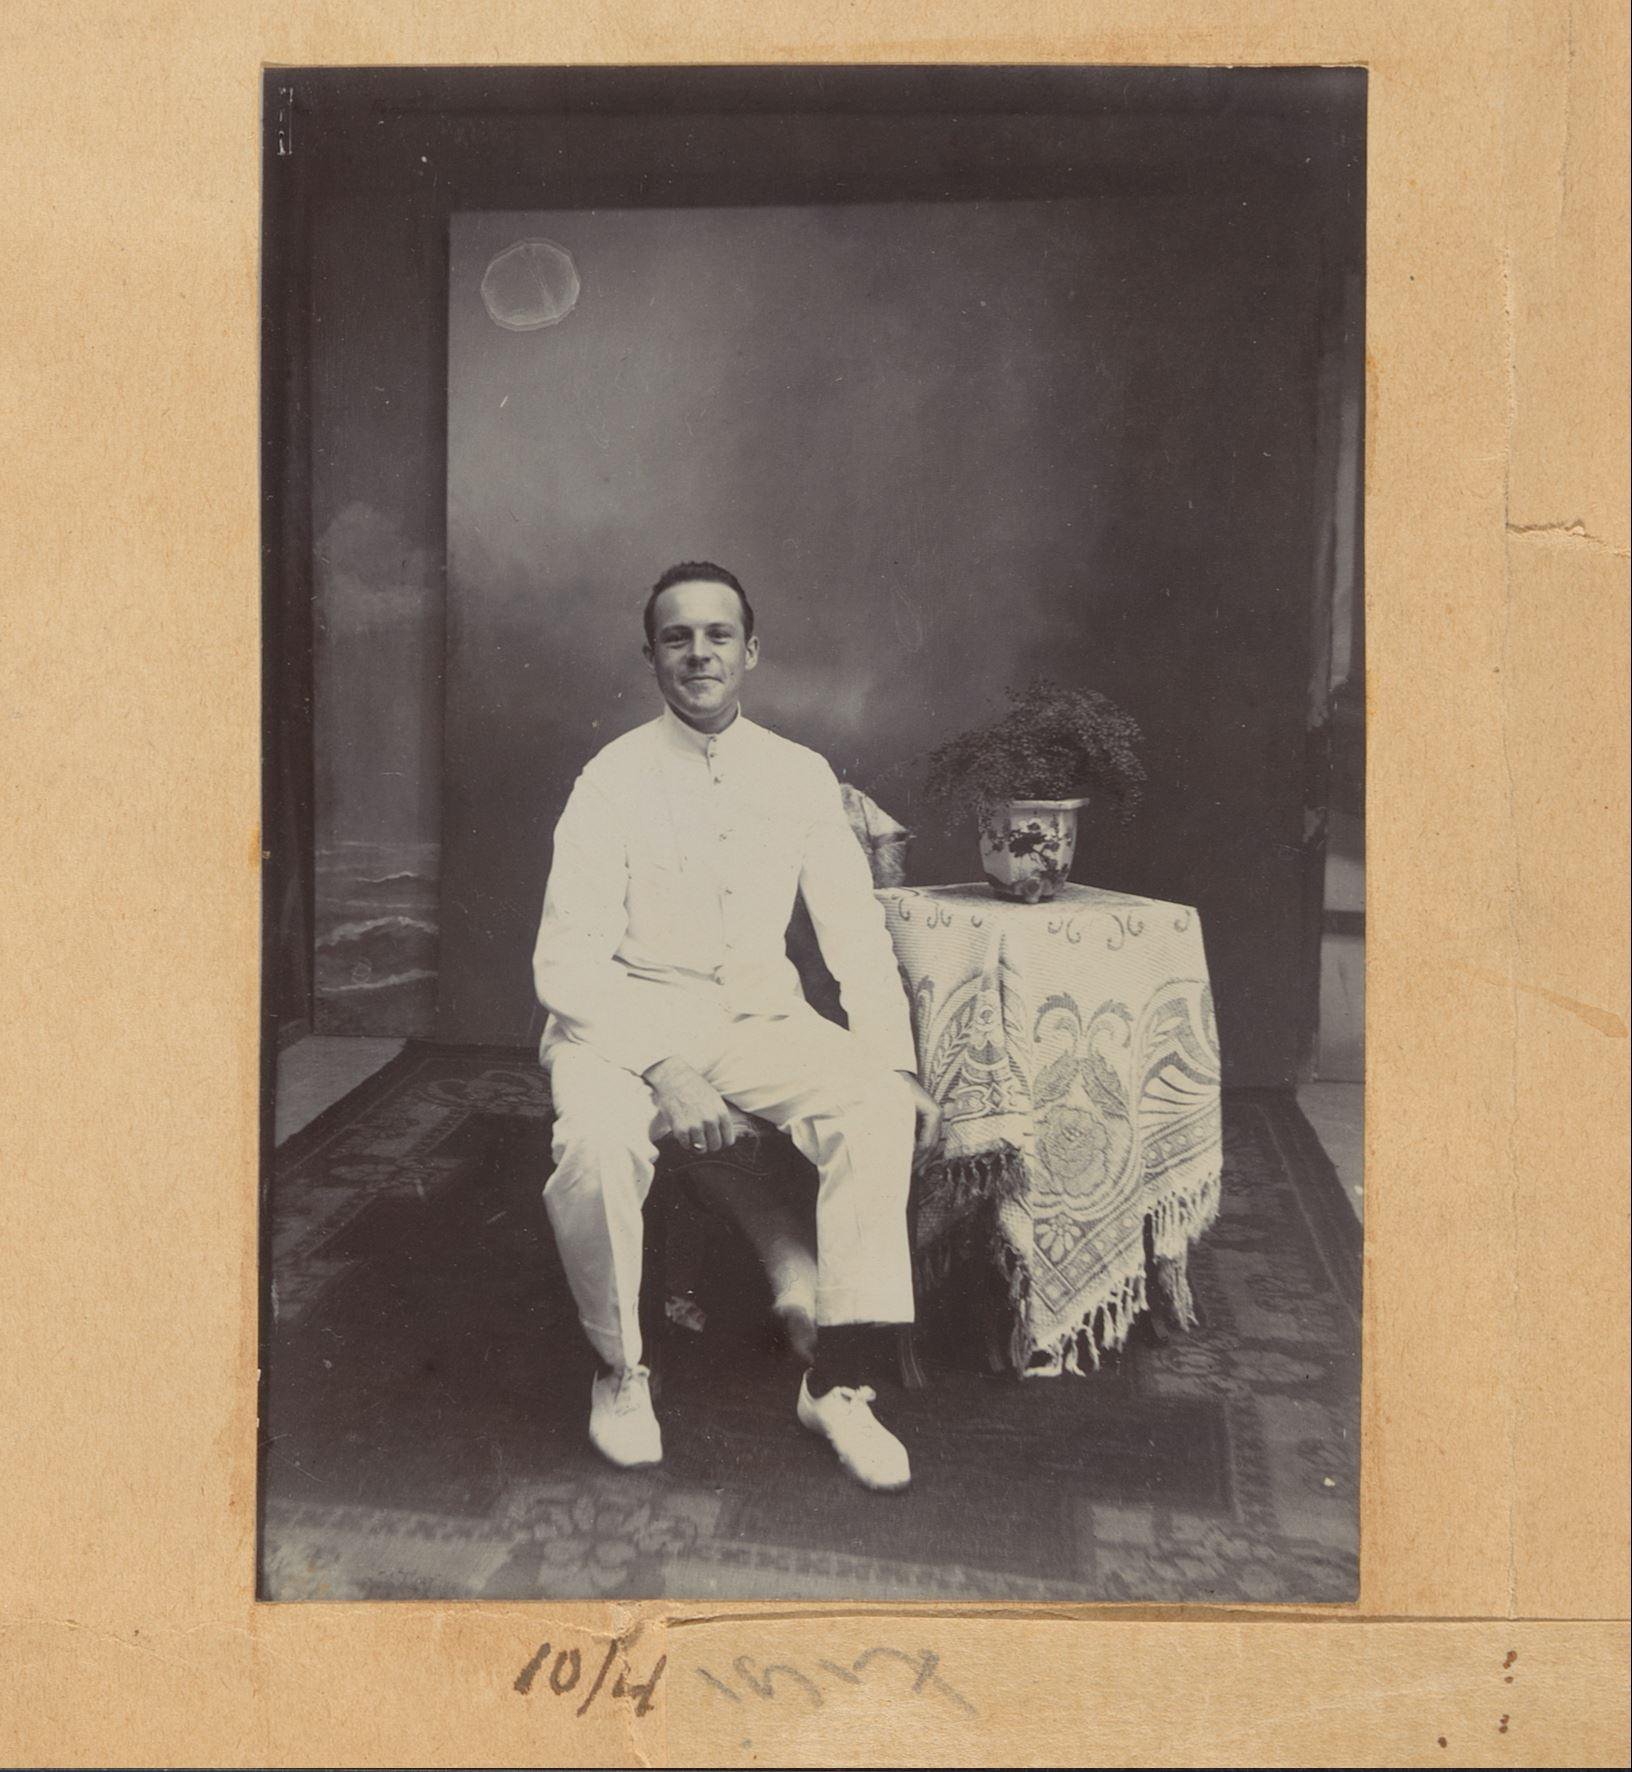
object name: photograph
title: Portret van een zittende Europese man, vermoedelijk in Jogjakarta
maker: Anonymous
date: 1917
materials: photographic support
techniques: gelatin silver print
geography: jogjakarta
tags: studio requisites ~ photographer, adult man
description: Onderdeel van Familiealbum met foto's van een familie in de voormalige kolonie Nederlands-Indië en van een suikerfabriek in Purworejo.